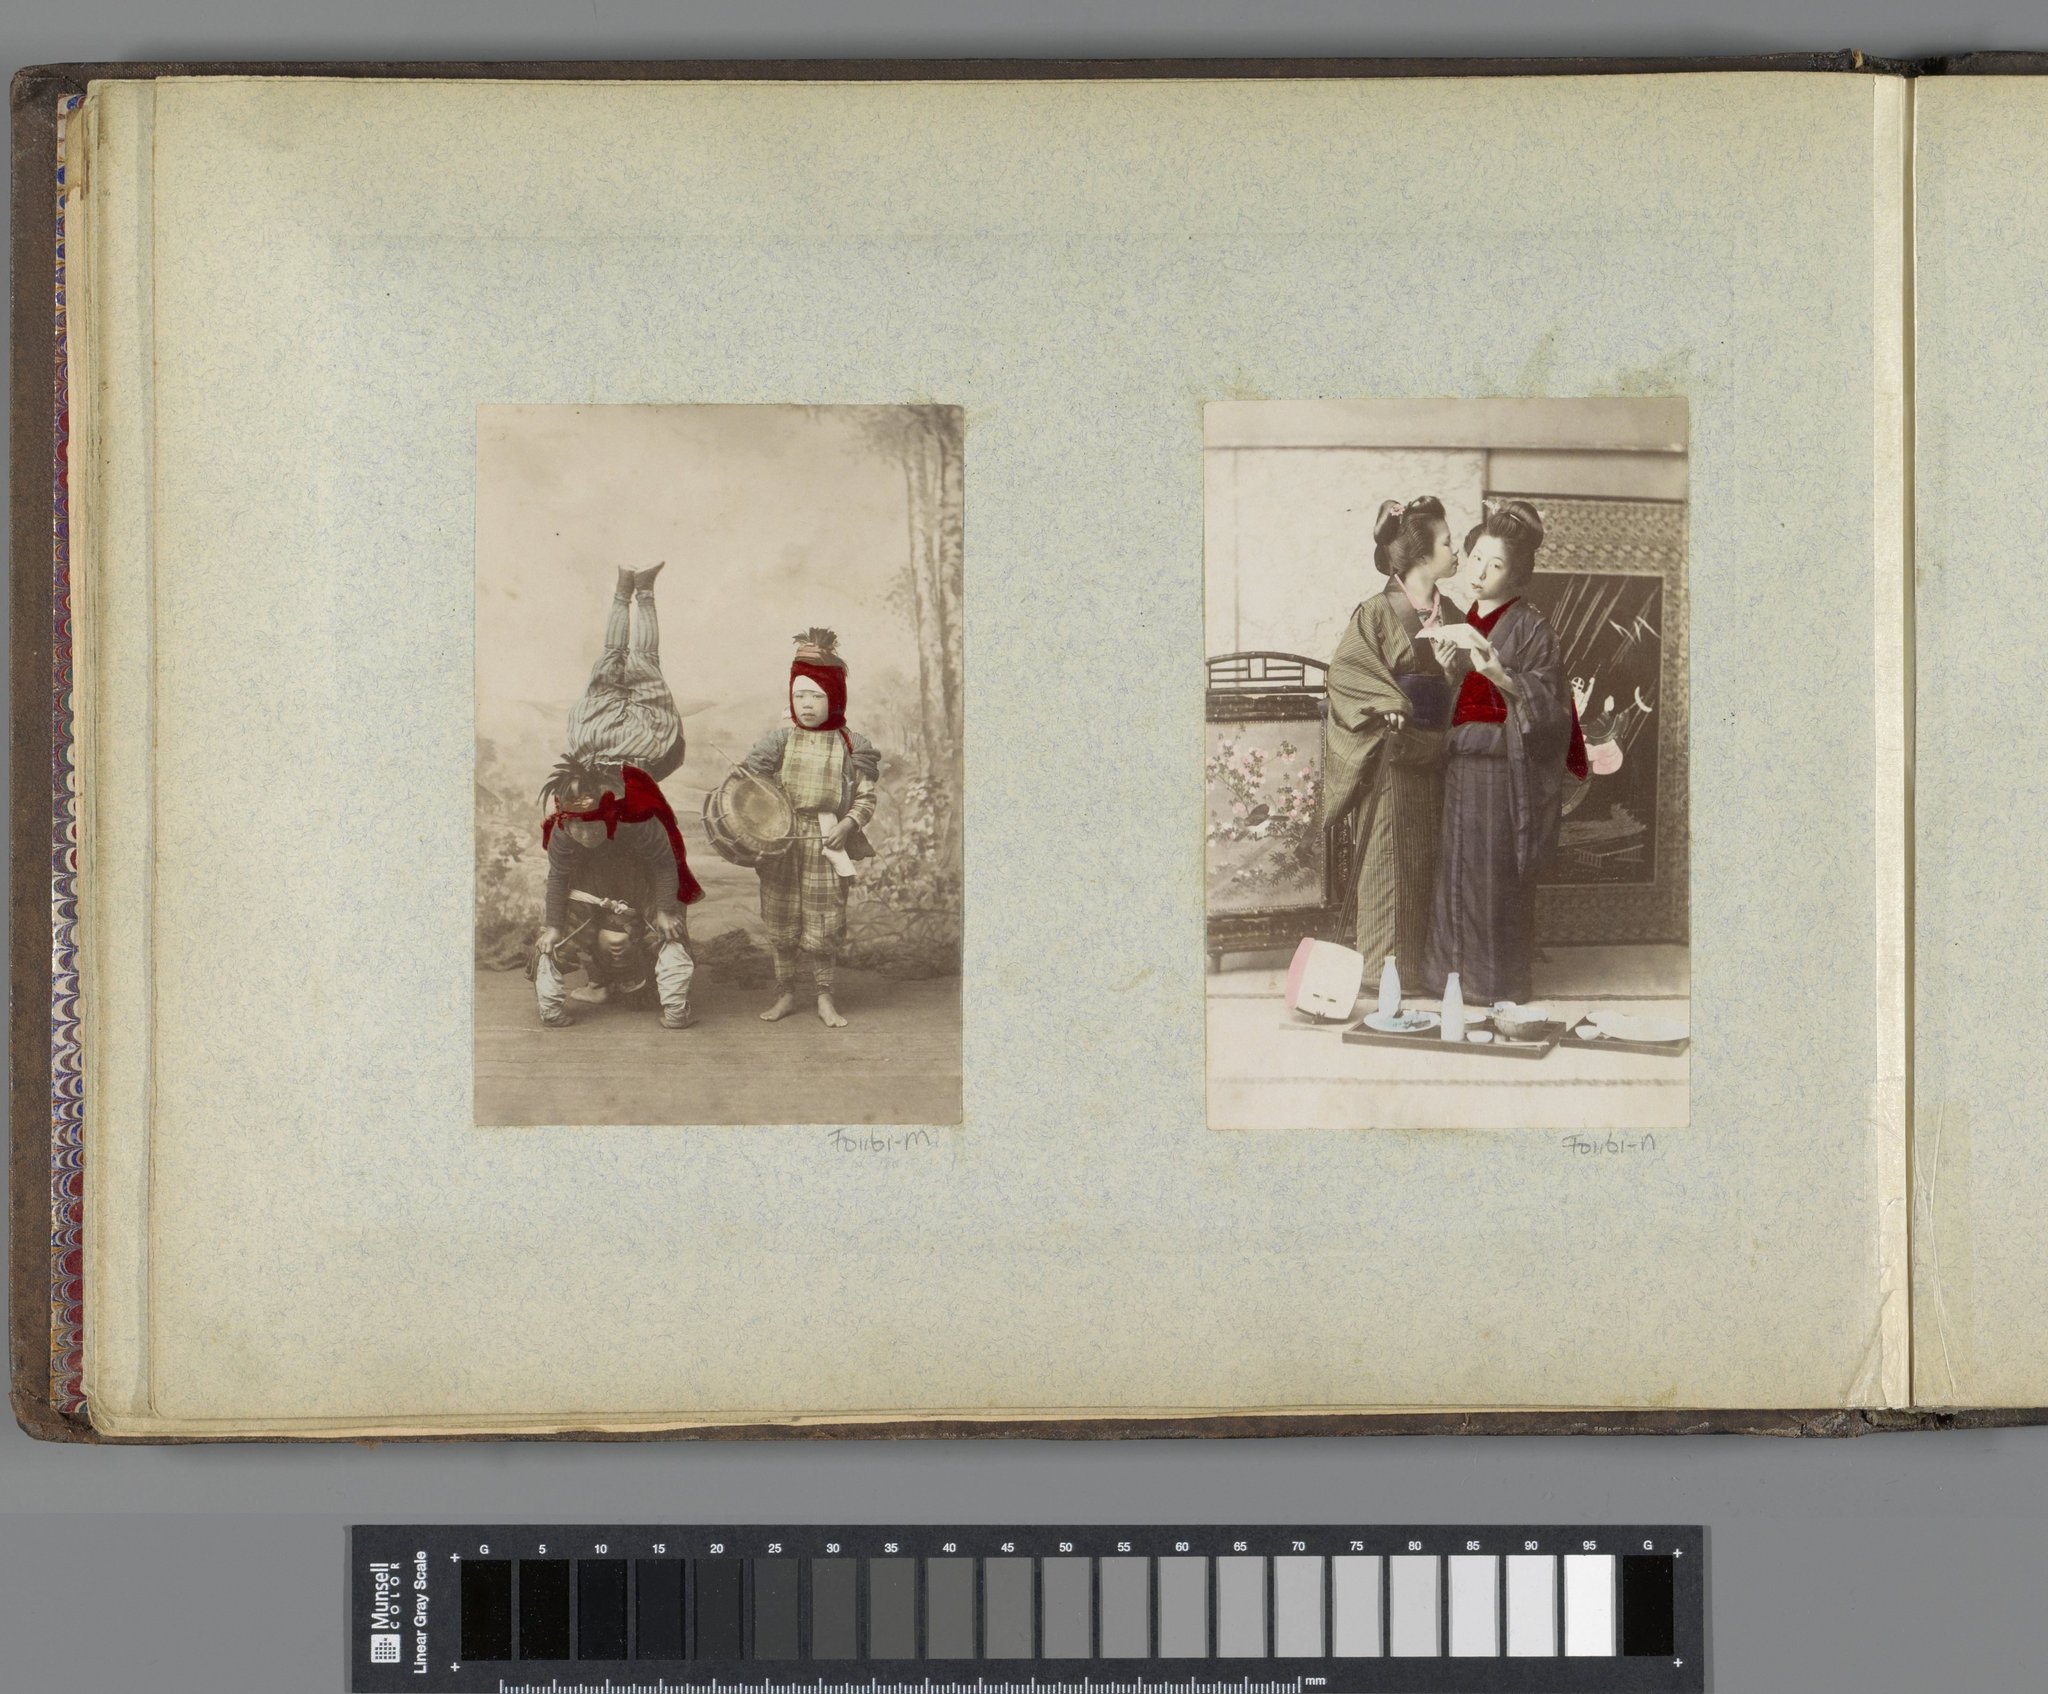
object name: photograph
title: Portret van twee Japanse vrouwen, met kamerschermen en dienbladen met serviesgoed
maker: Anonymous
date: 1870-1891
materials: paper, photographic support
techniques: albumen print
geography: japan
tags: adult woman, table-ware, screen, folding screen, japan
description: Onderdeel van Fotoalbum van een reis naar Manilla.